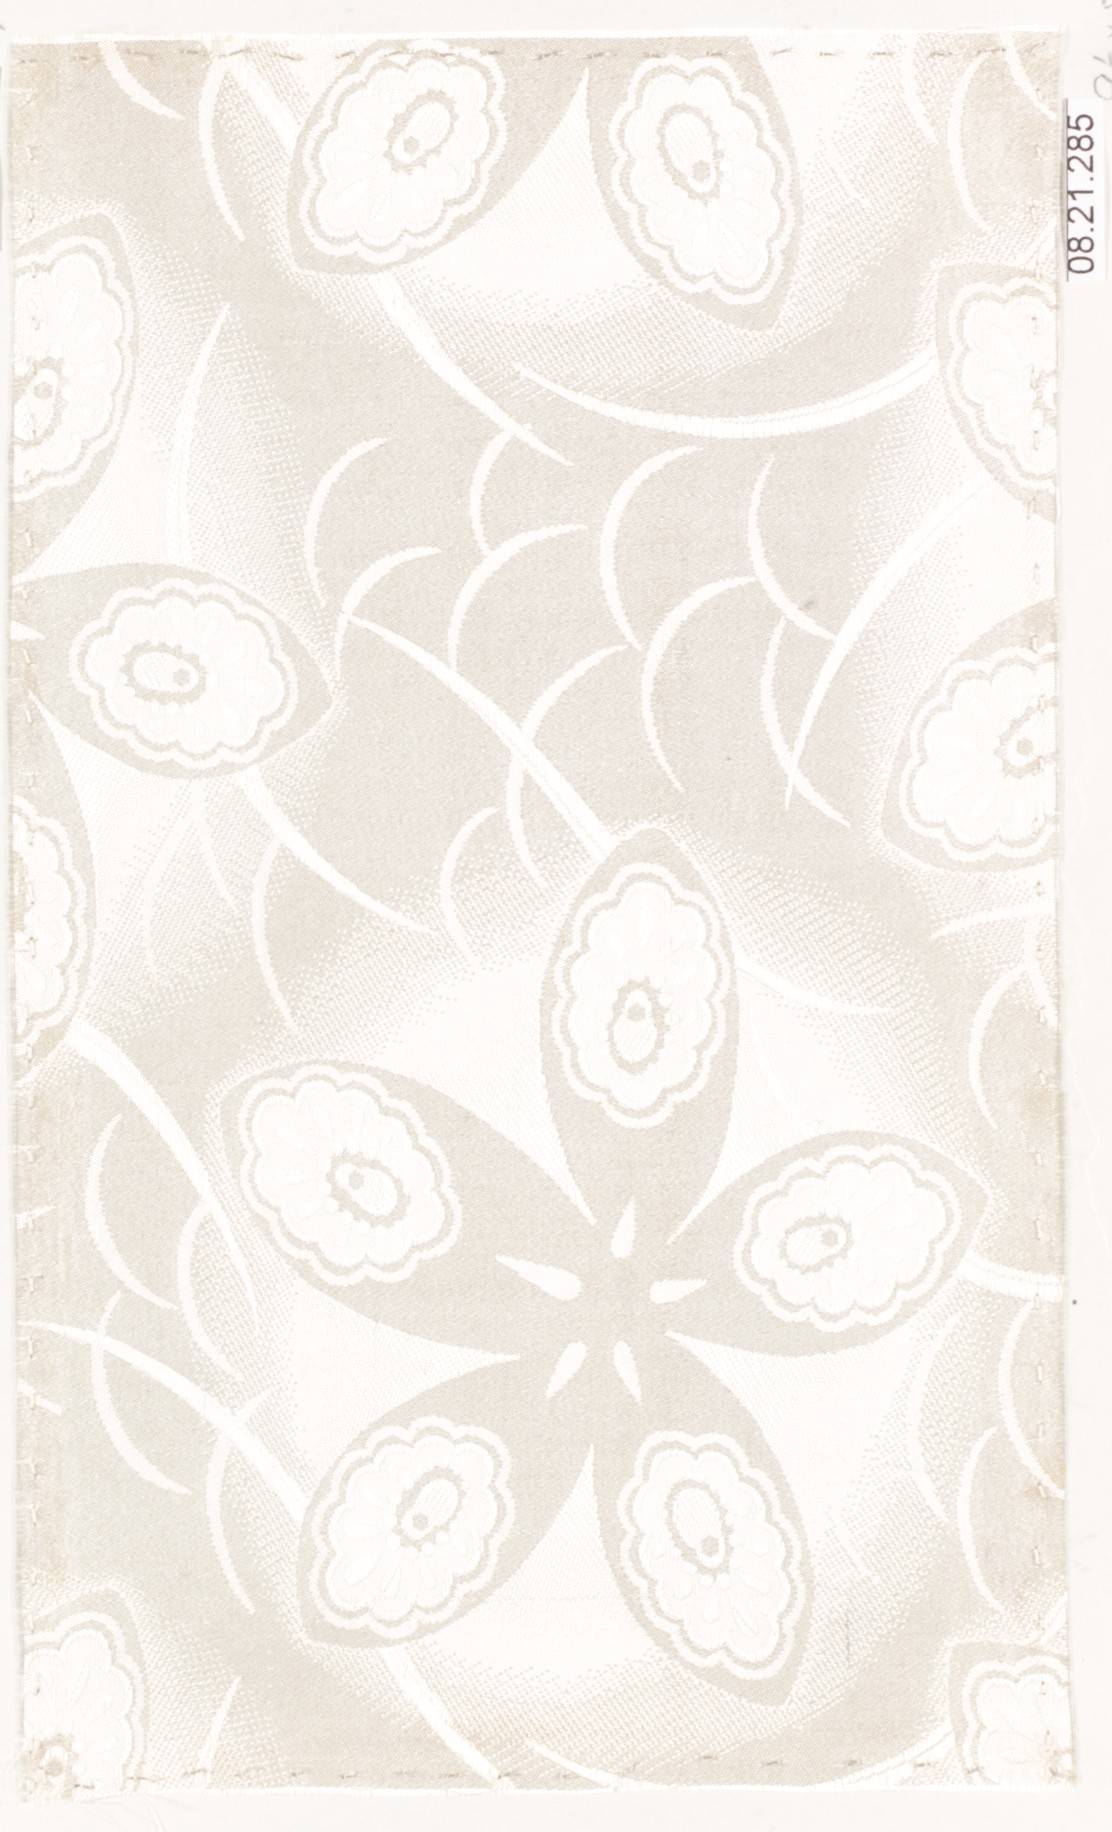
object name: textile sample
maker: Anonymous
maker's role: designer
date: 1900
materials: silk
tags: flowers